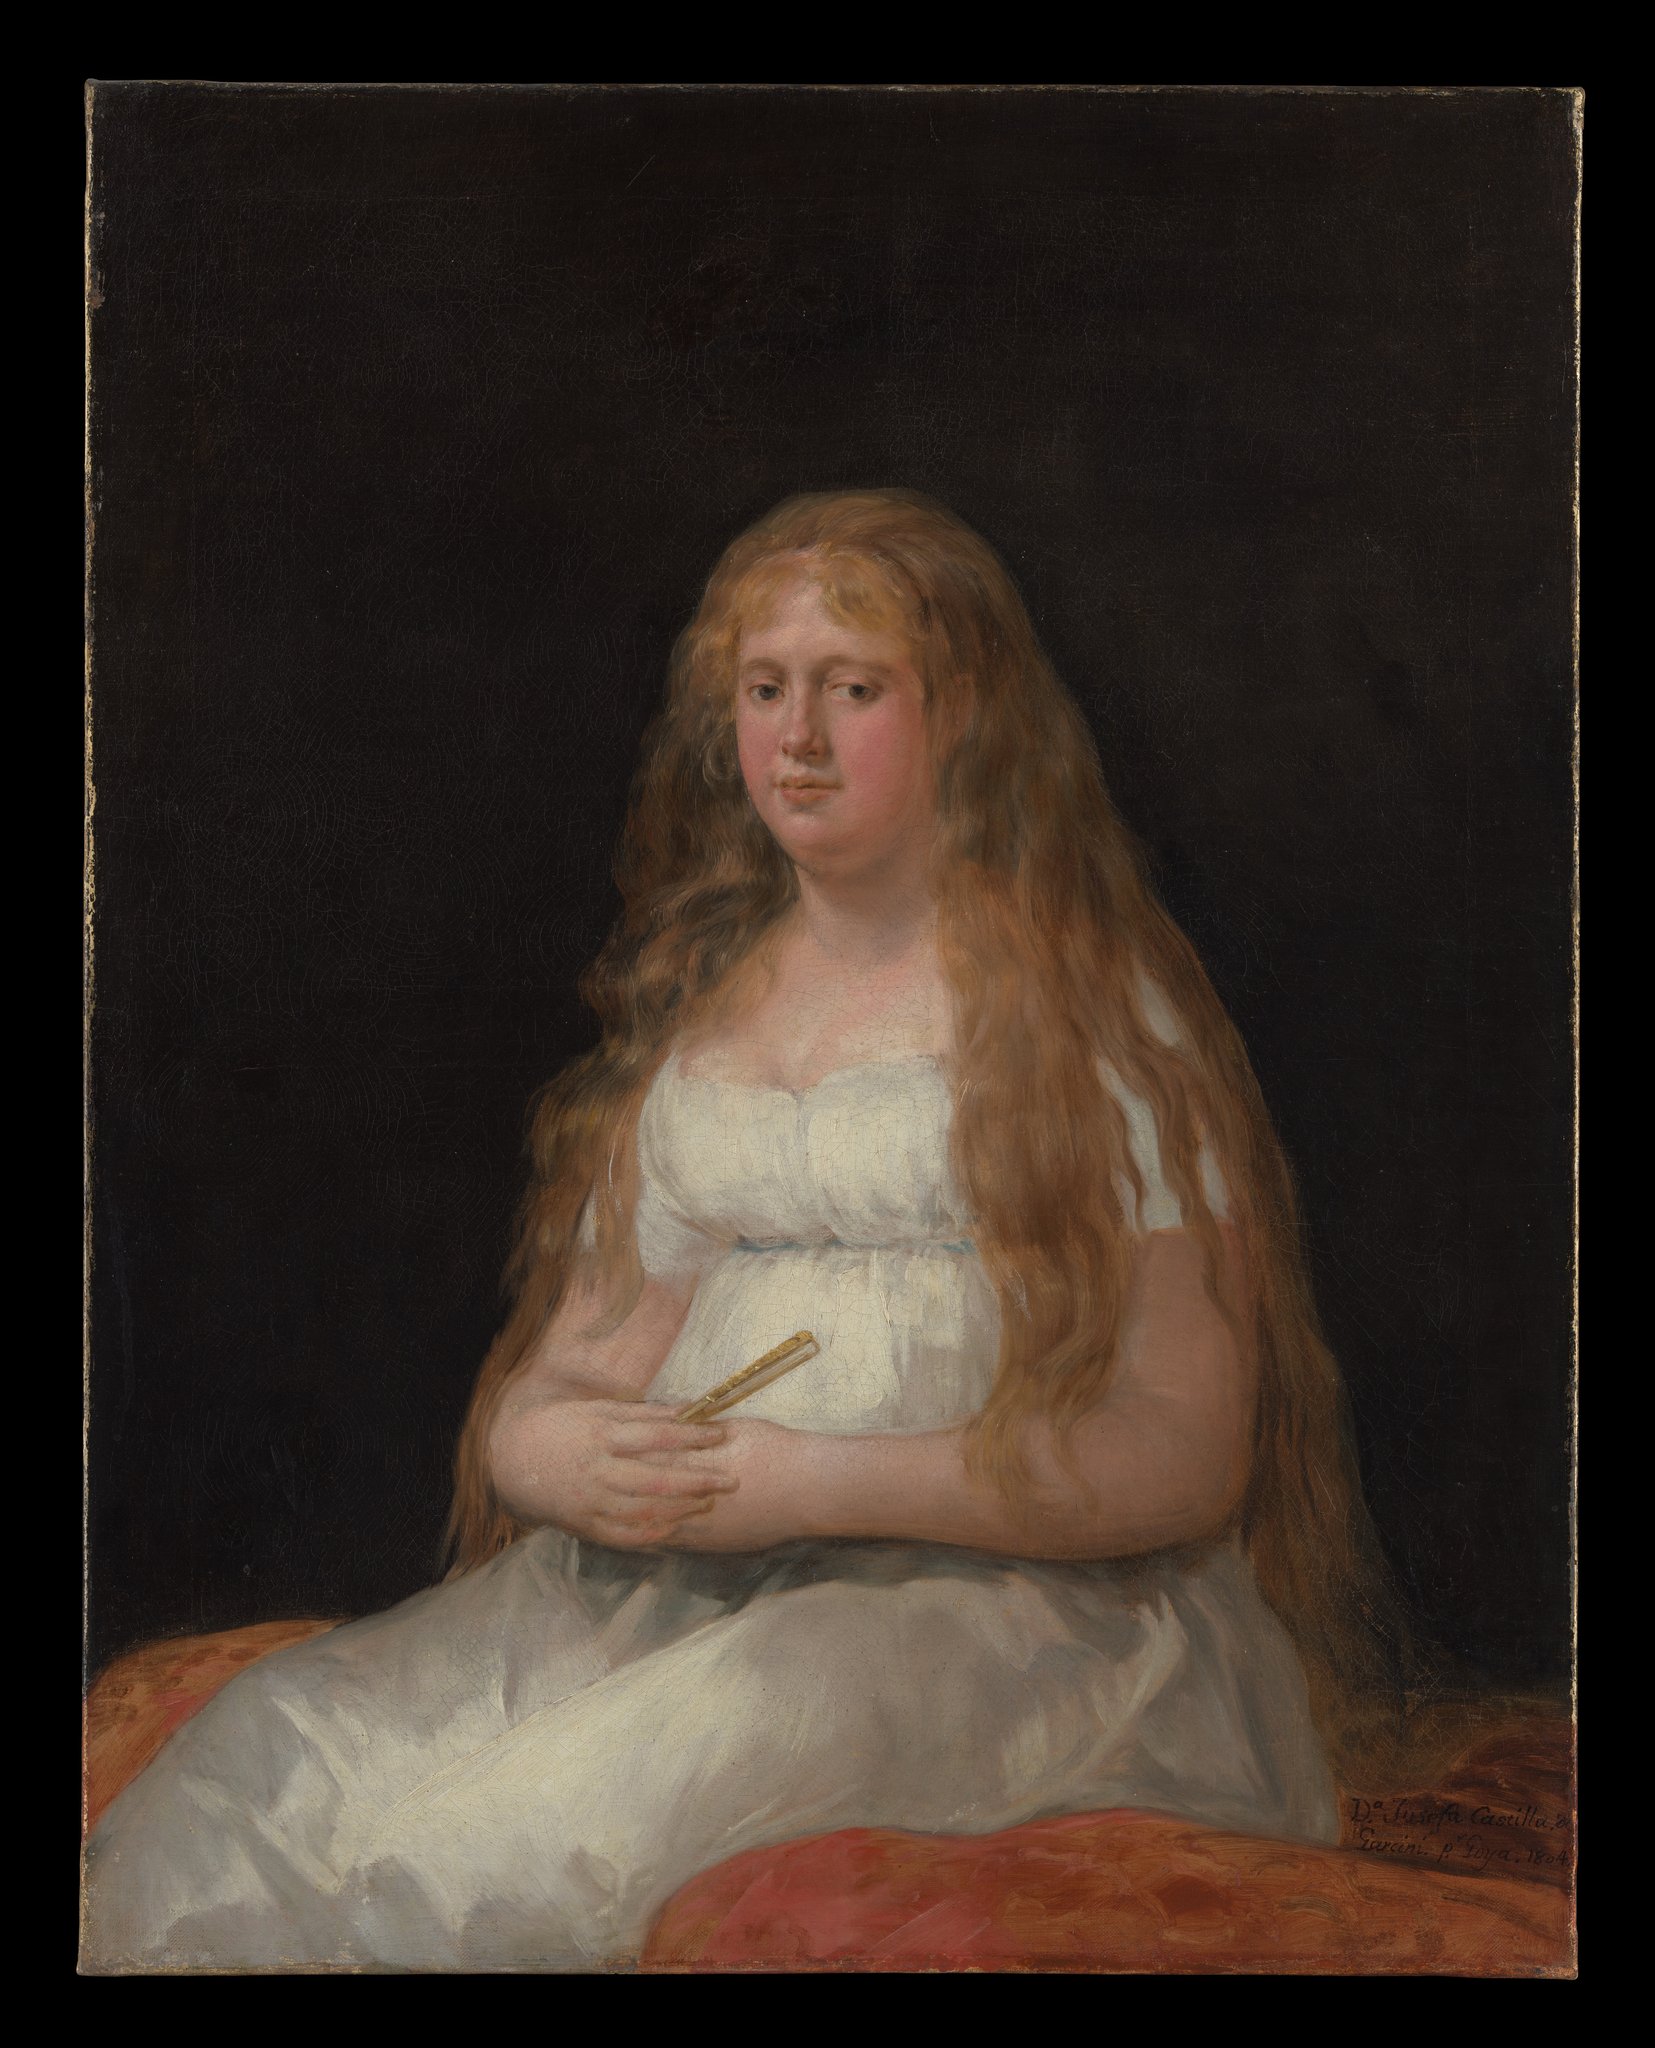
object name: painting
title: Josefa de Castilla Portugal y van Asbrock de Garcini (1775–about 1850)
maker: goya (francisco de goya y lucientes)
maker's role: artist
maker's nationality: spanish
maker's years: 1746-1828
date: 1804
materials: canvas, oil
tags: portraits,women